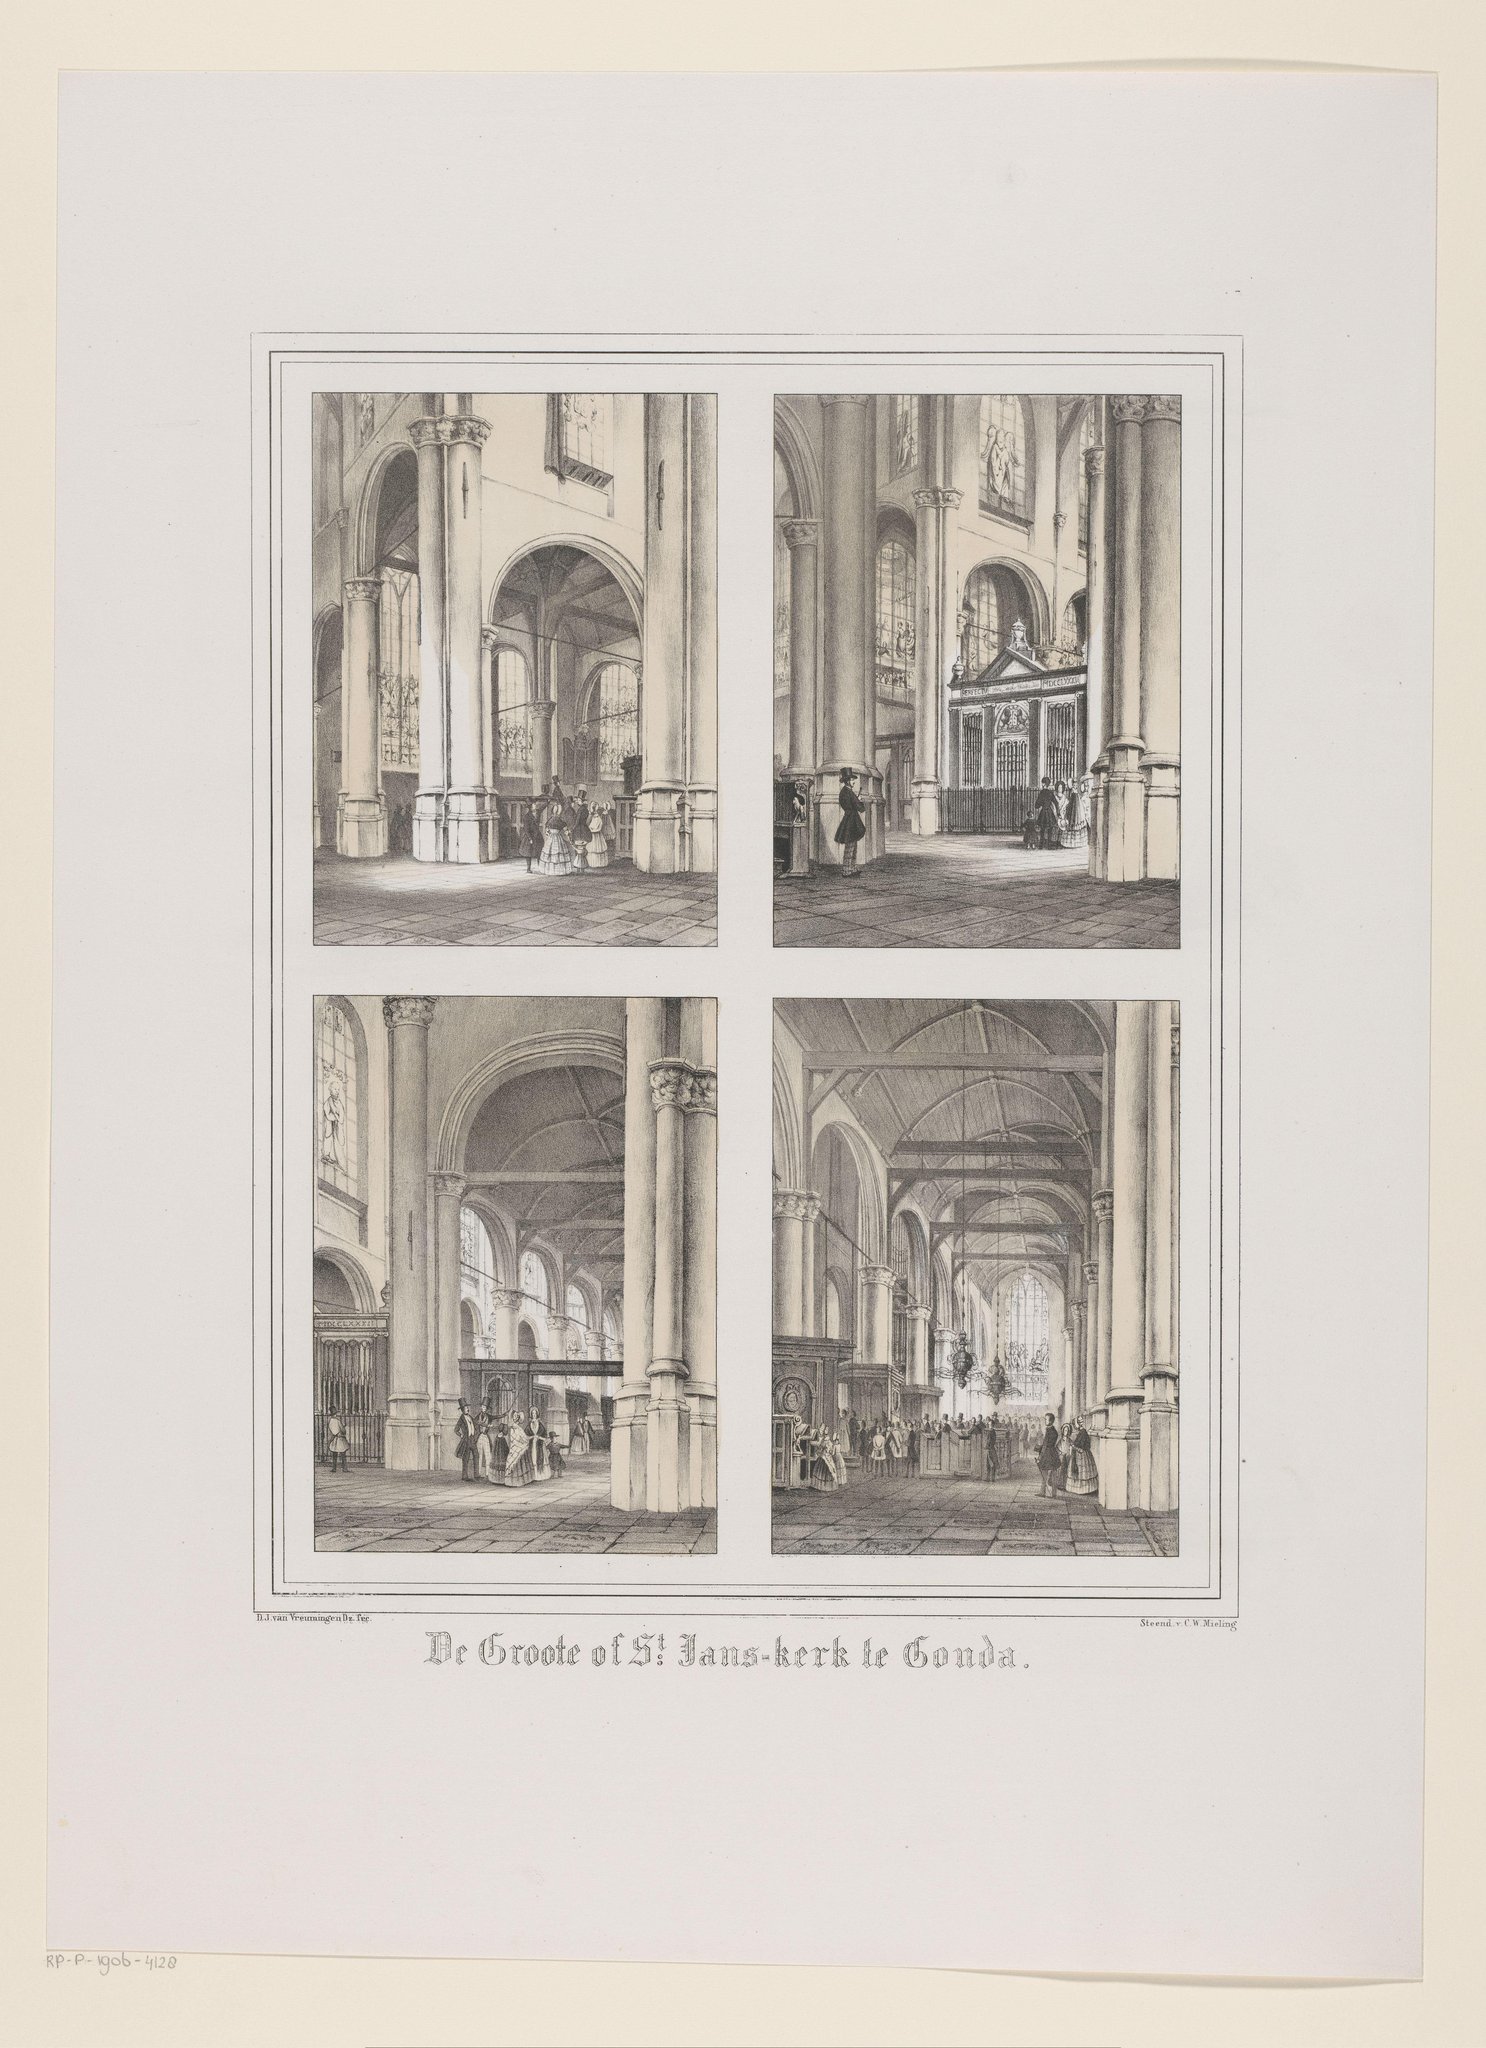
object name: print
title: Interieur van de Sint-Janskerk te Gouda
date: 1847-1865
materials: paper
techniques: tone lithography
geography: the hague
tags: interior of church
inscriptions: collector's mark: Lugt 2228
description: Links boven: Gezicht op de linkerzijde bij de noordelijke ingang. Rechts boven: Gezicht op het koorhek. Links onder: Gezicht op de oostzijde van het koor. Rechts onder: Gezicht op het glas-in-lood raam naast de toren bij de noordelijke ingang.